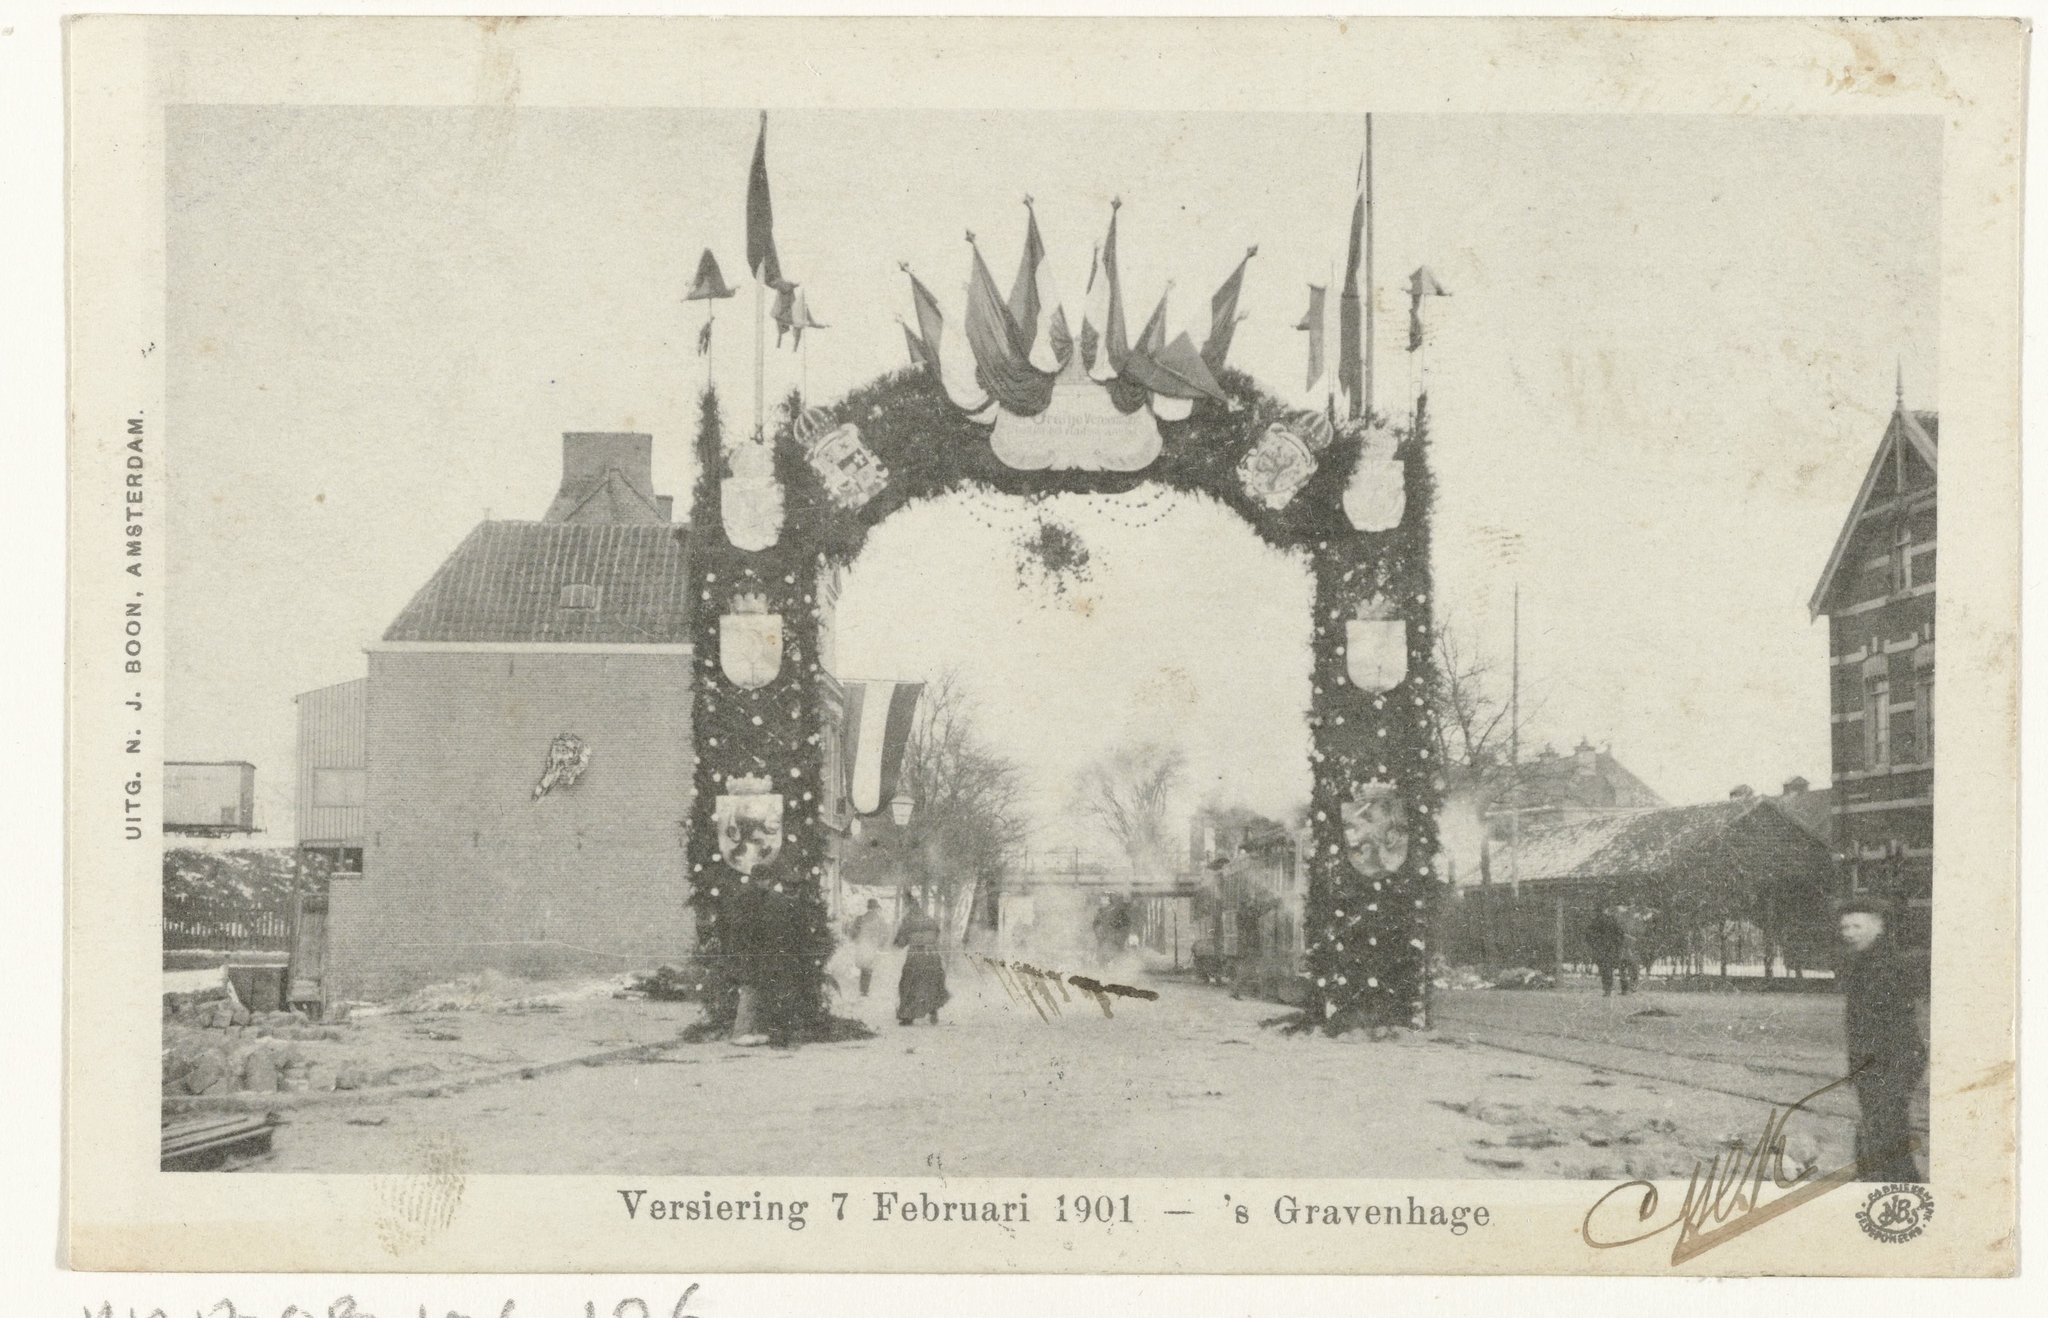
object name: photomechanical print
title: Versieringen bij het huwelijk van Wilhelmina, koningin der Nederlanden, en Hendrik van Mecklenburg-Schwerin te Den Haag op 7 februari 1901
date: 1901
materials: paper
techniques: photograph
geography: amsterdam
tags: the hague, wilhelmina of the netherlands, hendrik (prins der nederlanden (1876-1934)), (civil) marriage ceremonies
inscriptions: inscription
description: De hier vermelde titel verwijst naar de hoogst verkregen titel van de geportretteerde, niet per se naar de titel die de geportretteerde op deze voorstelling draagt.